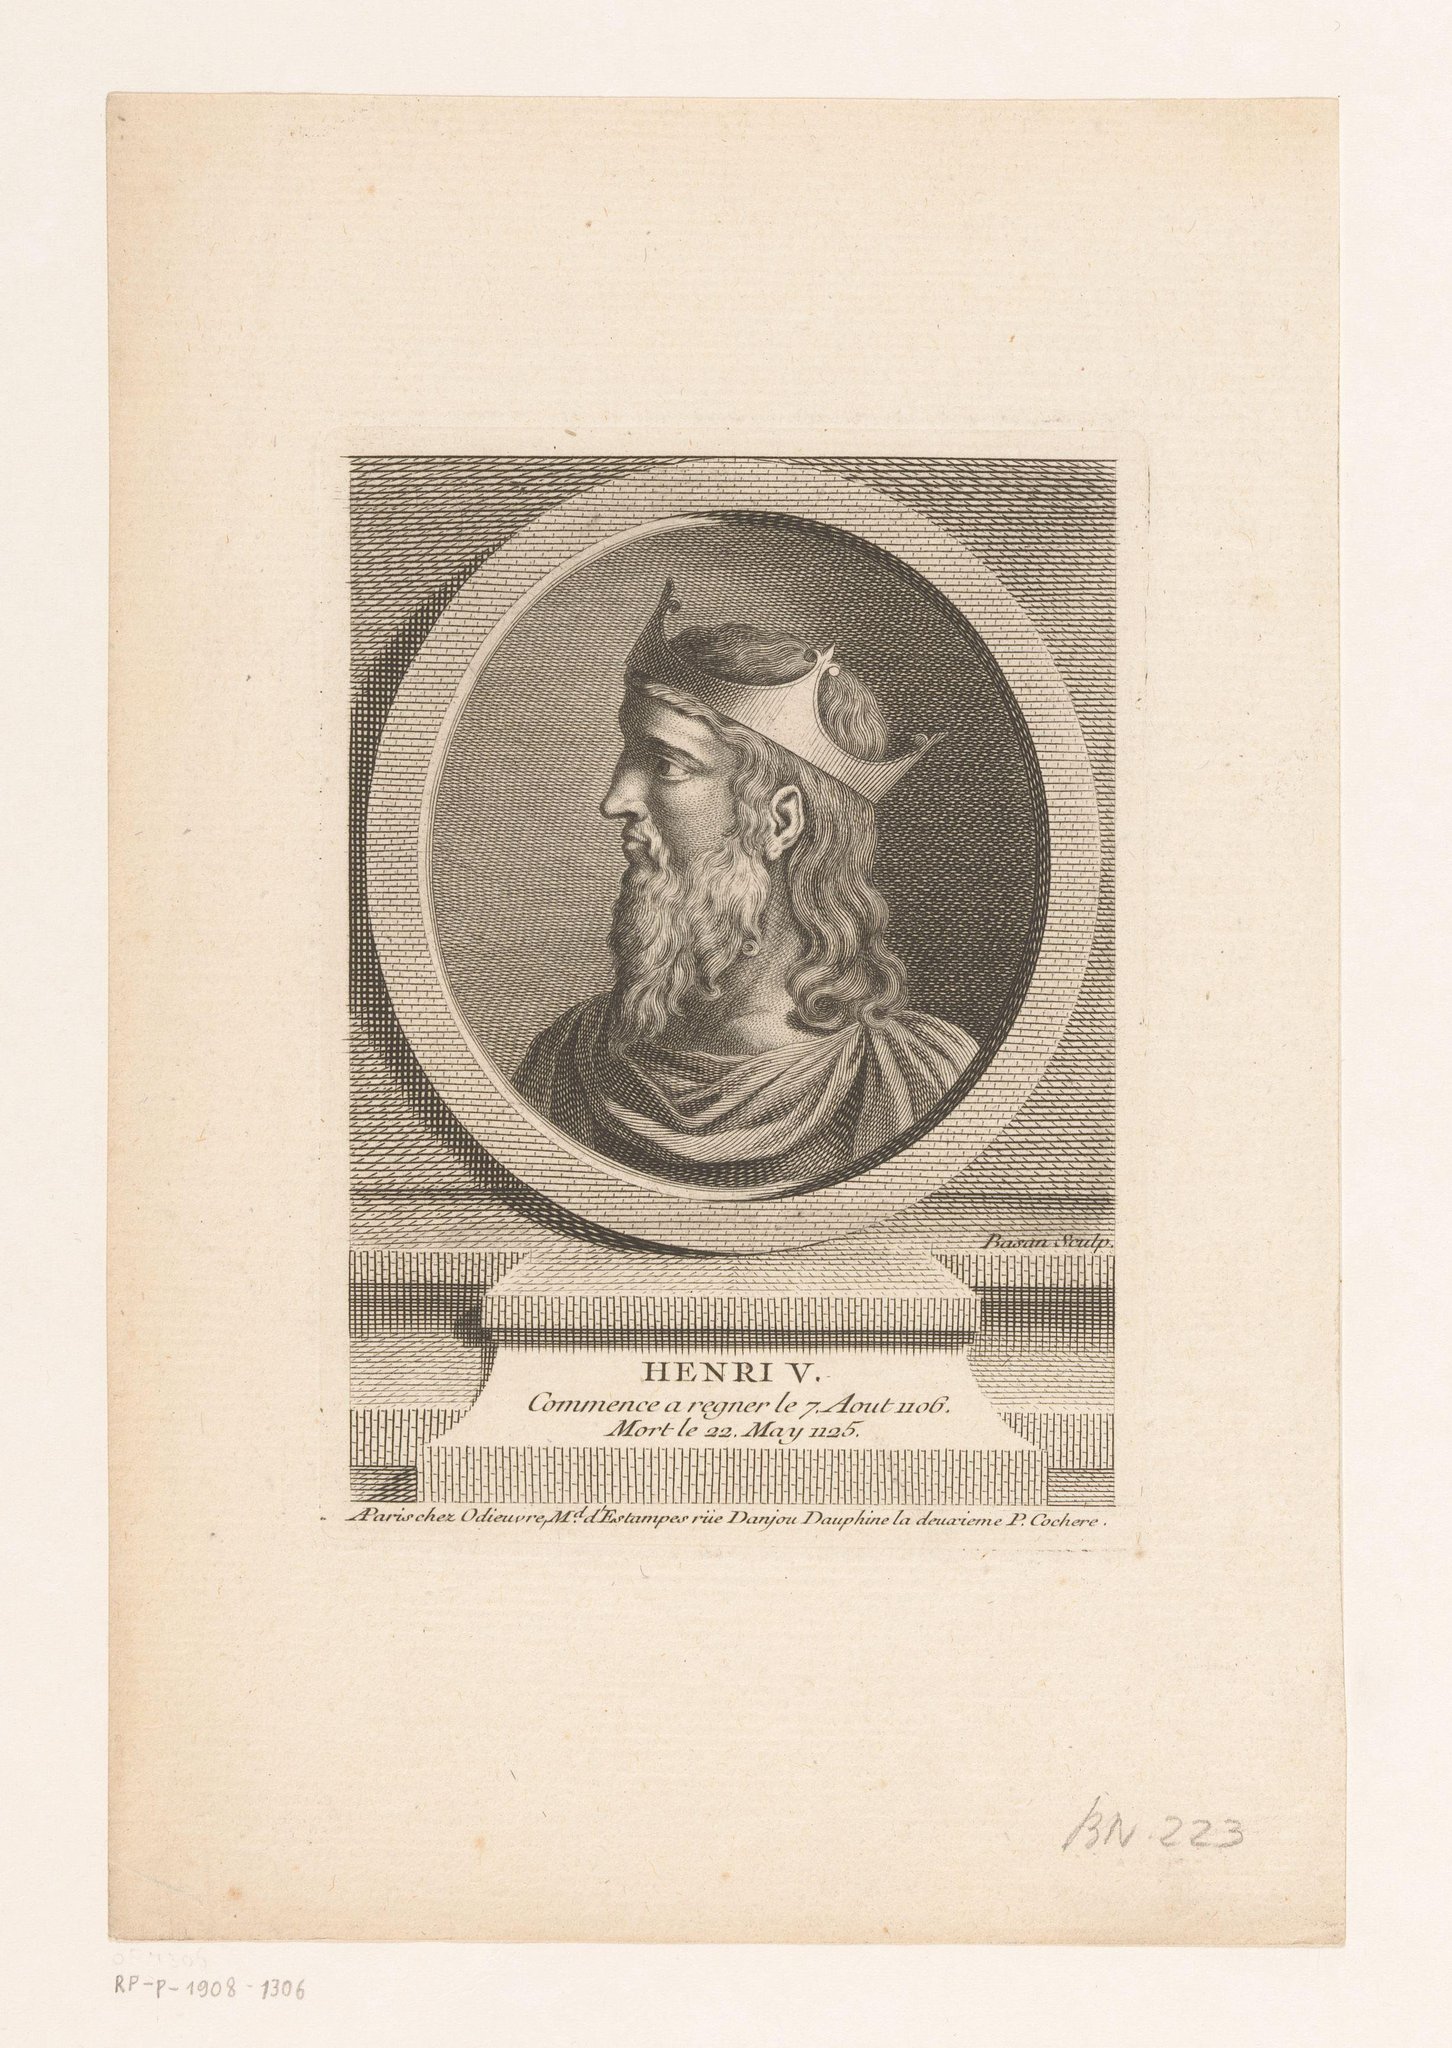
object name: print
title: Portret van keizer Hendrik V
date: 1733-1756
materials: paper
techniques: engraving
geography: paris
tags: ornament ~ medallion, historical persons, ruler, sovereign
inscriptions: collector's mark: Lugt 2228